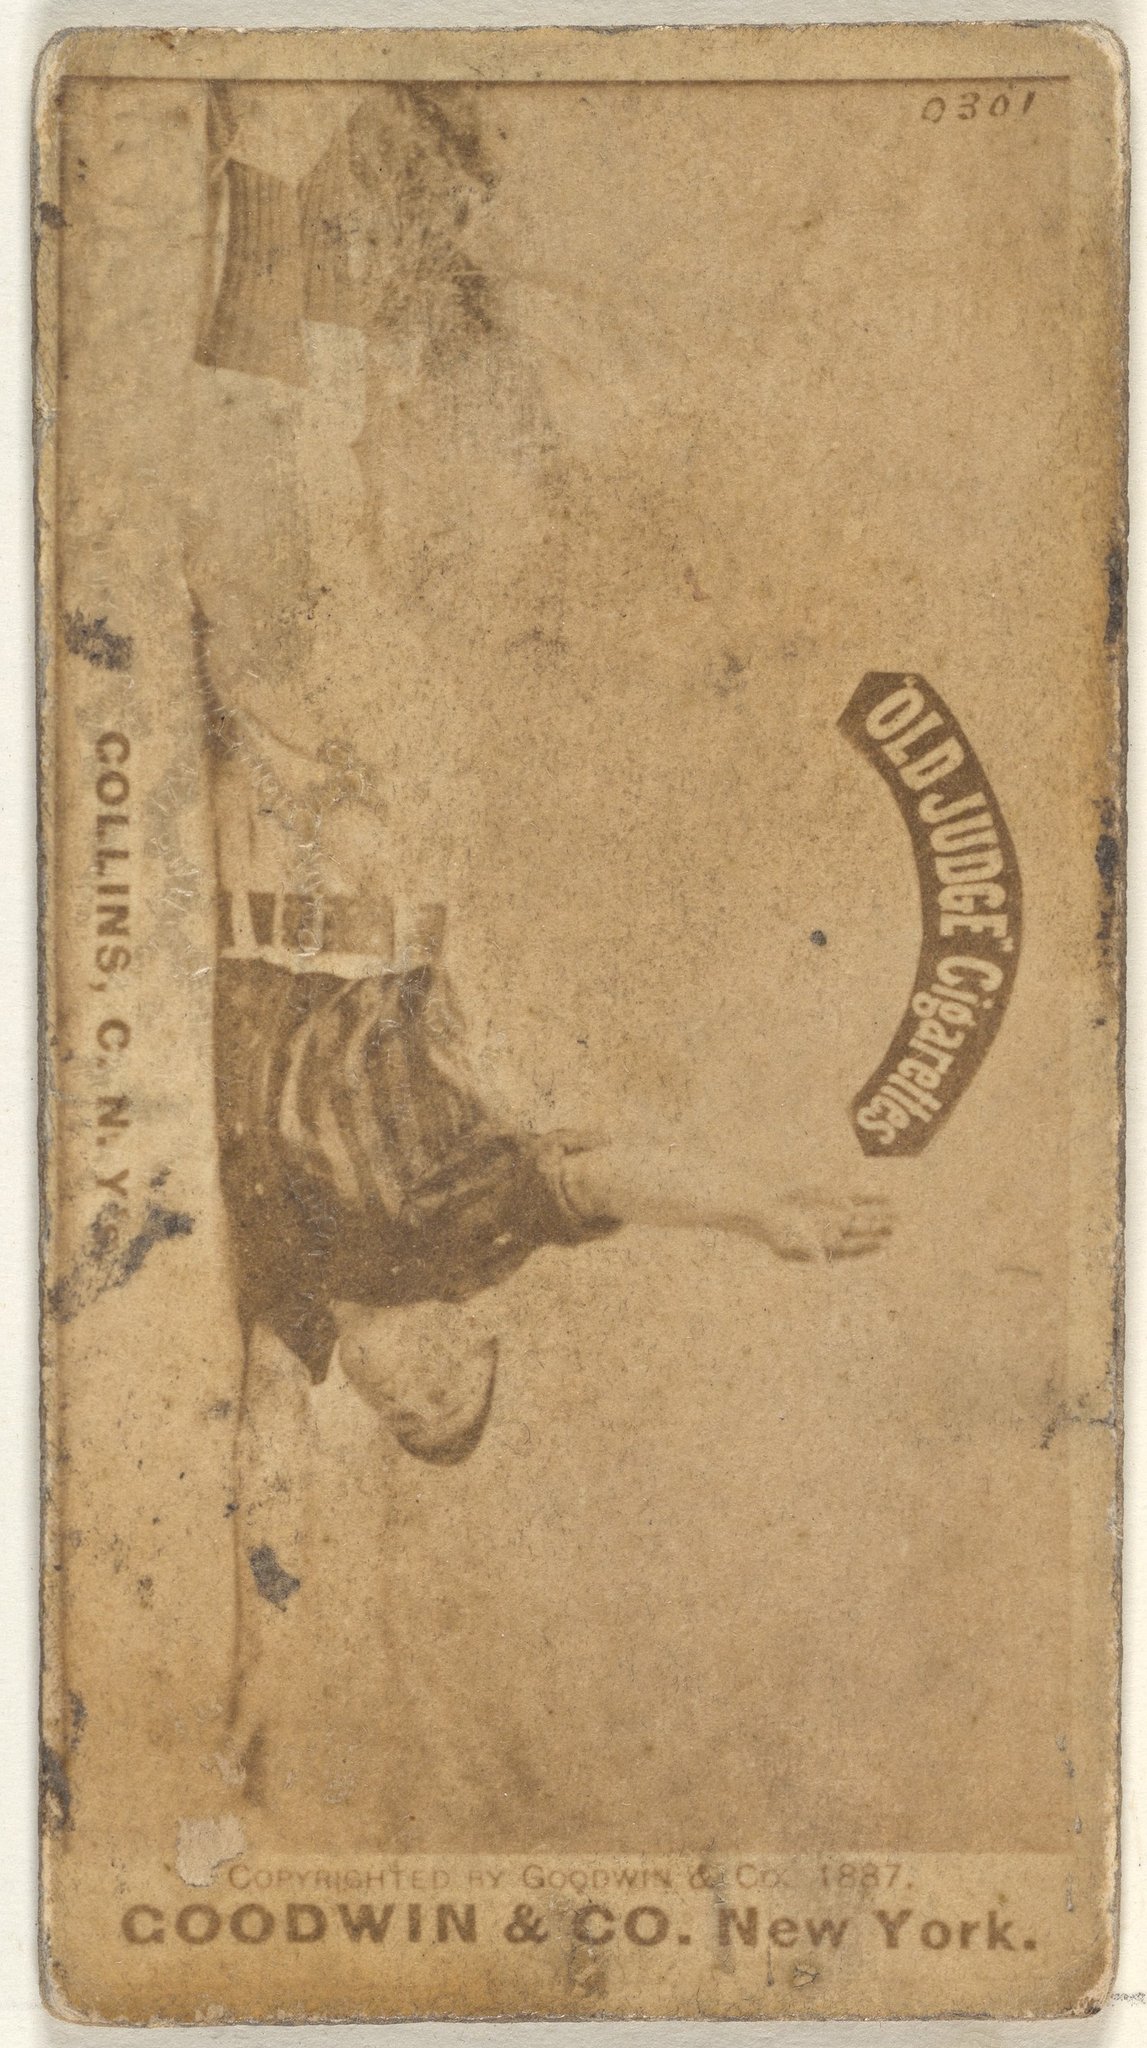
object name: baseball card, photograph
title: William J. "Bill" Collins, Catcher, New York, from the Old Judge series (N172) for Old Judge Cigarettes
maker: goodwin & company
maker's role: publisher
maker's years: 1850-1950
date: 1887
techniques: albumen silver print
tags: men,portraits,baseball,athletes